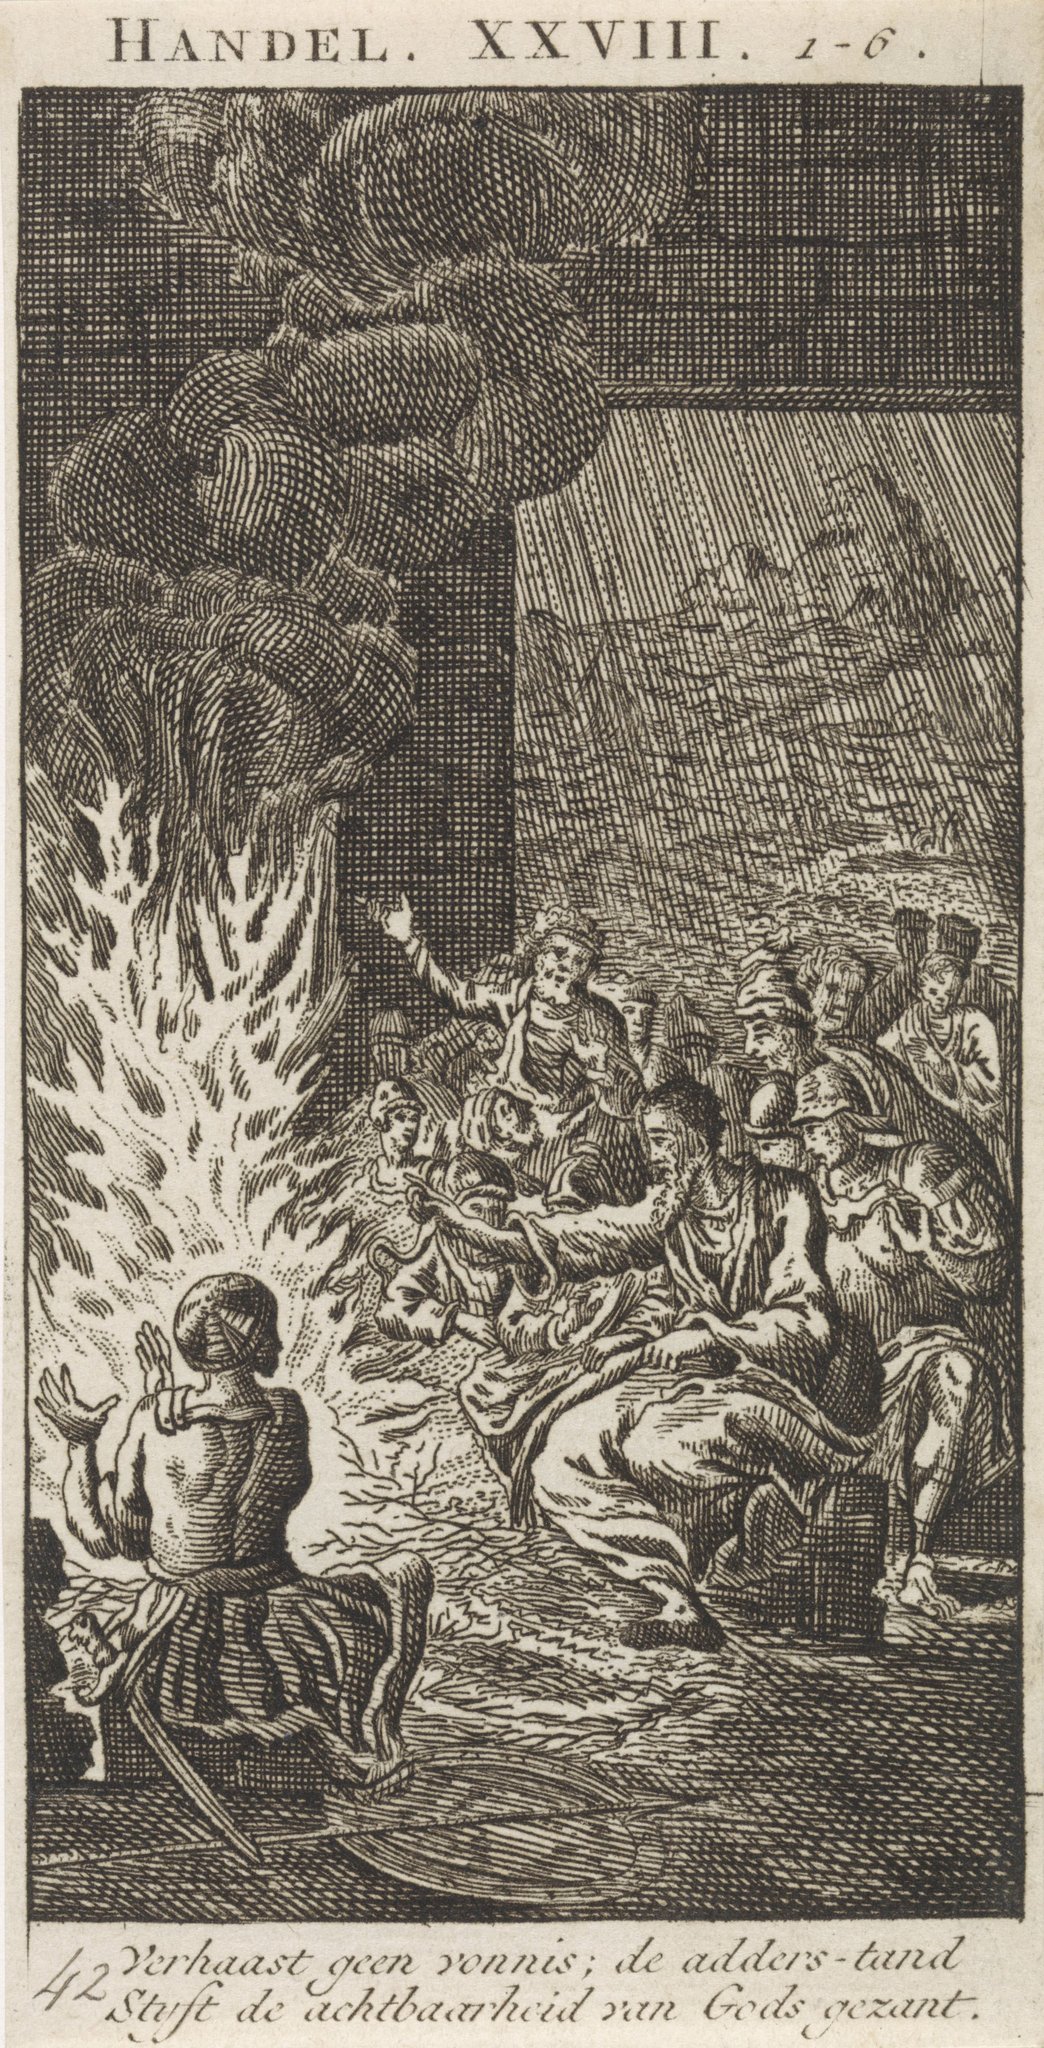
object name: print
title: Paulus wordt gebeten door een adder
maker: Anonymous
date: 1712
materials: paper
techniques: etching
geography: amsterdam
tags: paul bitten by a viper (when throwing wood on the fire)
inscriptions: collector's mark: Lugt 2228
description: Kopie van illustratie voor: Luyken, Jan. Bybel printen. Amsterdam: Pieter Arentsz. II (wed.) en Cornelis van der Sys, 1712, p. 41.